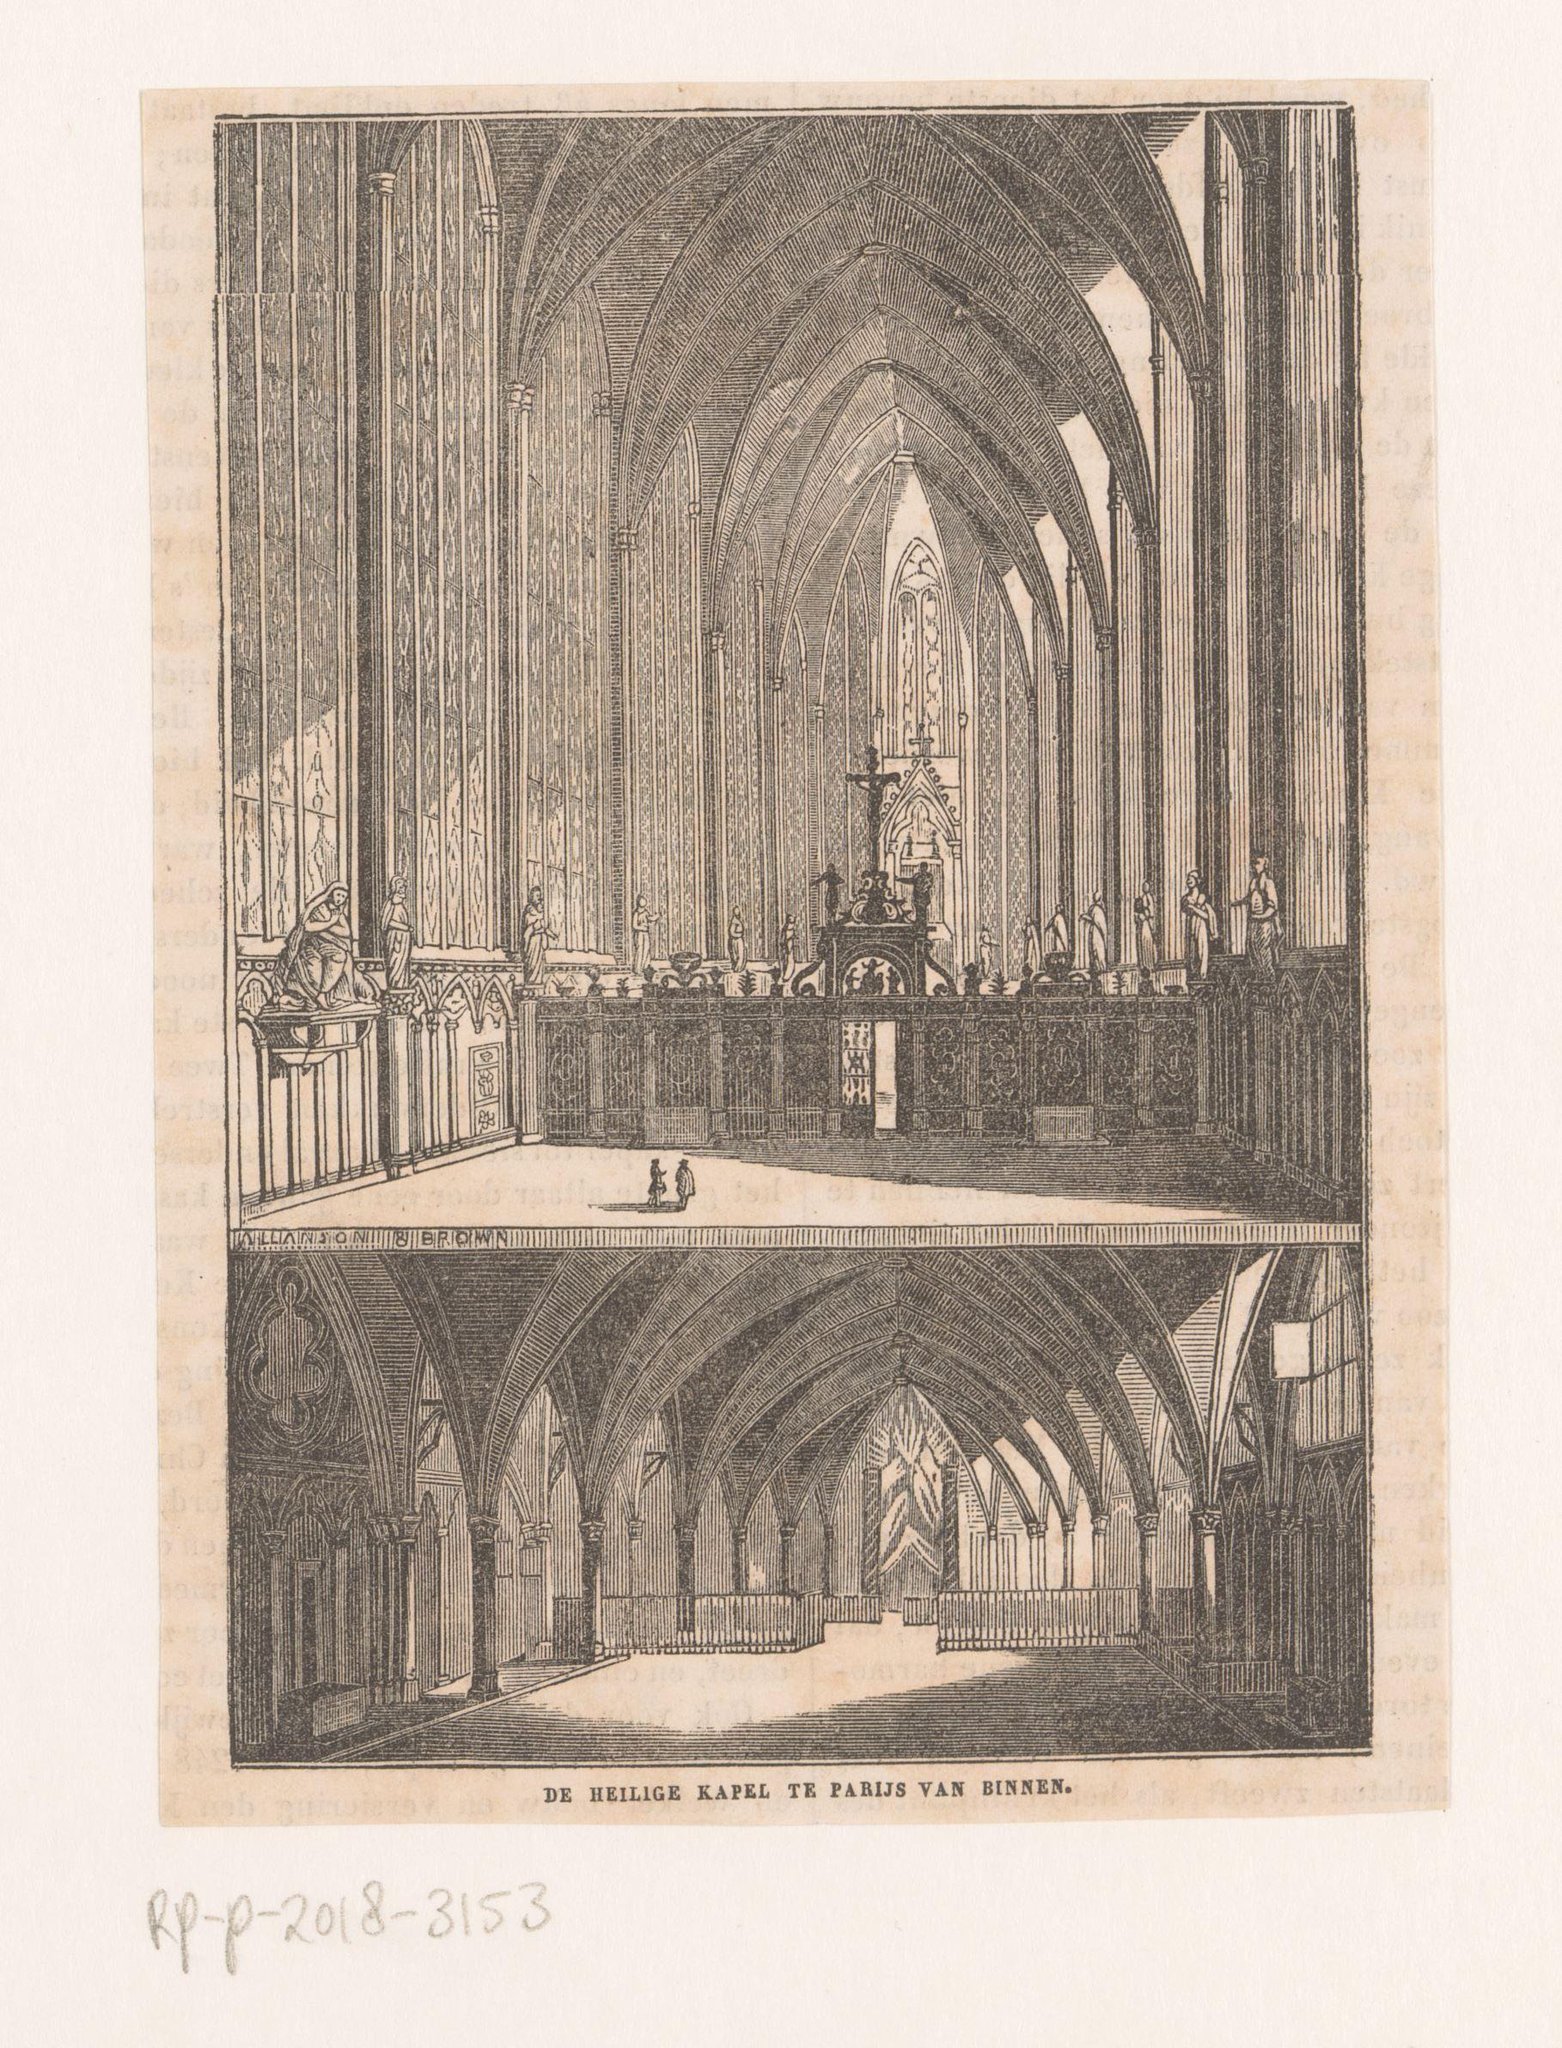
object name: book illustration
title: Gezicht op het interieur van de Sainte-Chapelle te Parijs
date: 1837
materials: paper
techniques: letterpress printing, engraving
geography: amsterdam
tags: roman catholic church, interior of church, paris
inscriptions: collector's mark: Lugt 2228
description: Prent uit: Nederlandsch Magazijn ter verspreiding van algemeene en nuttige kundigheden. Amsterdam: Gebroeders Diederichs, 1837.